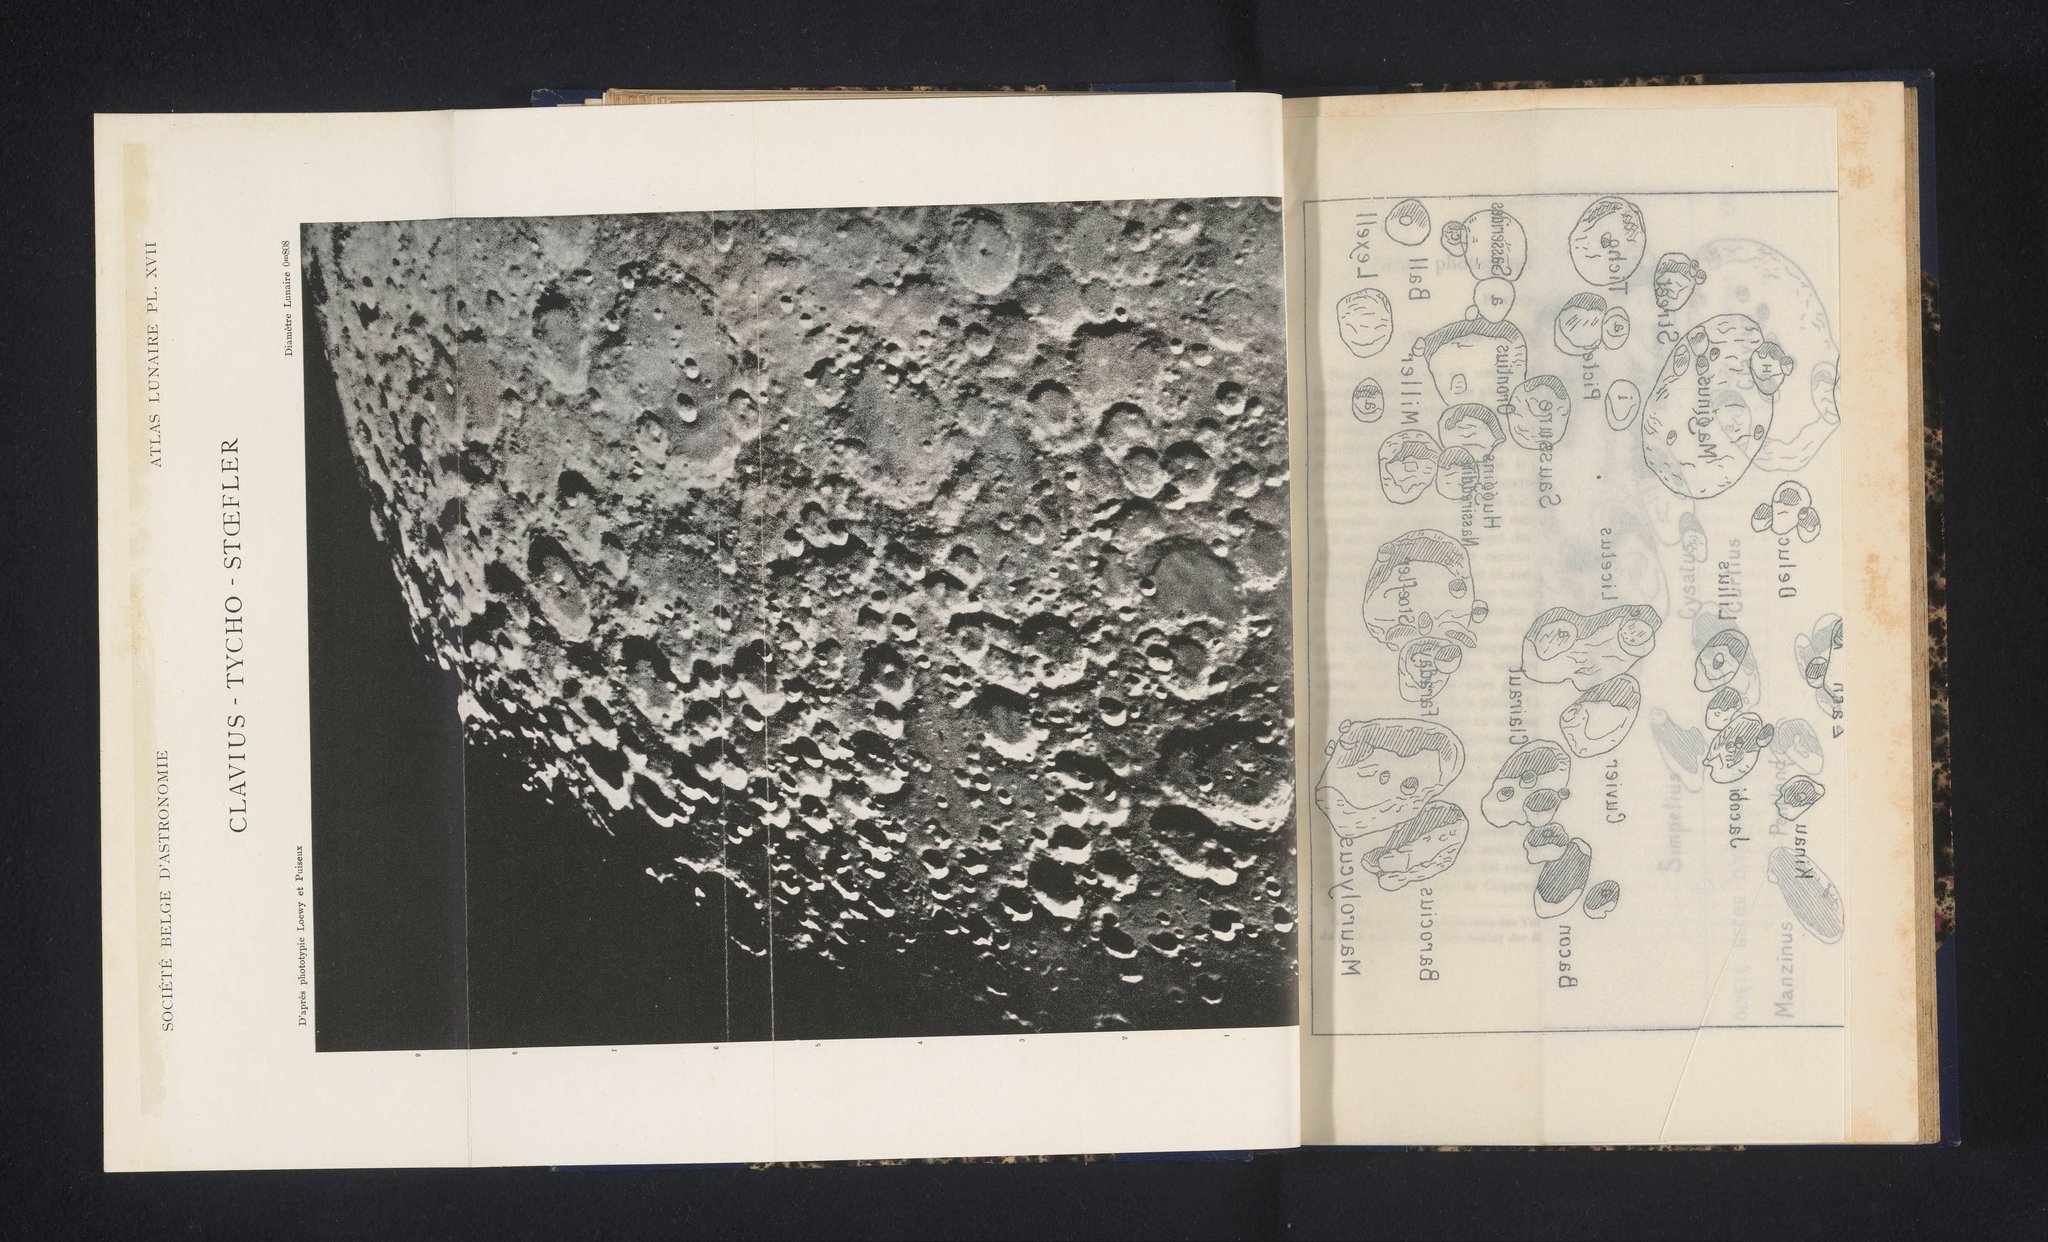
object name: photomechanical print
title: Kraters op de maan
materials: paper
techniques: autotype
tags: surface of the moon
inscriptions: inscription: ‘Société Belge D'Astronomie Atlas Lunaire Pl. XVII/ 1894, Septembre 19, 14 h. 1m. (T. M. de Paris)’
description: Transparante pagina voor prent als kaart met daarop de namen van de verschillende kraters.